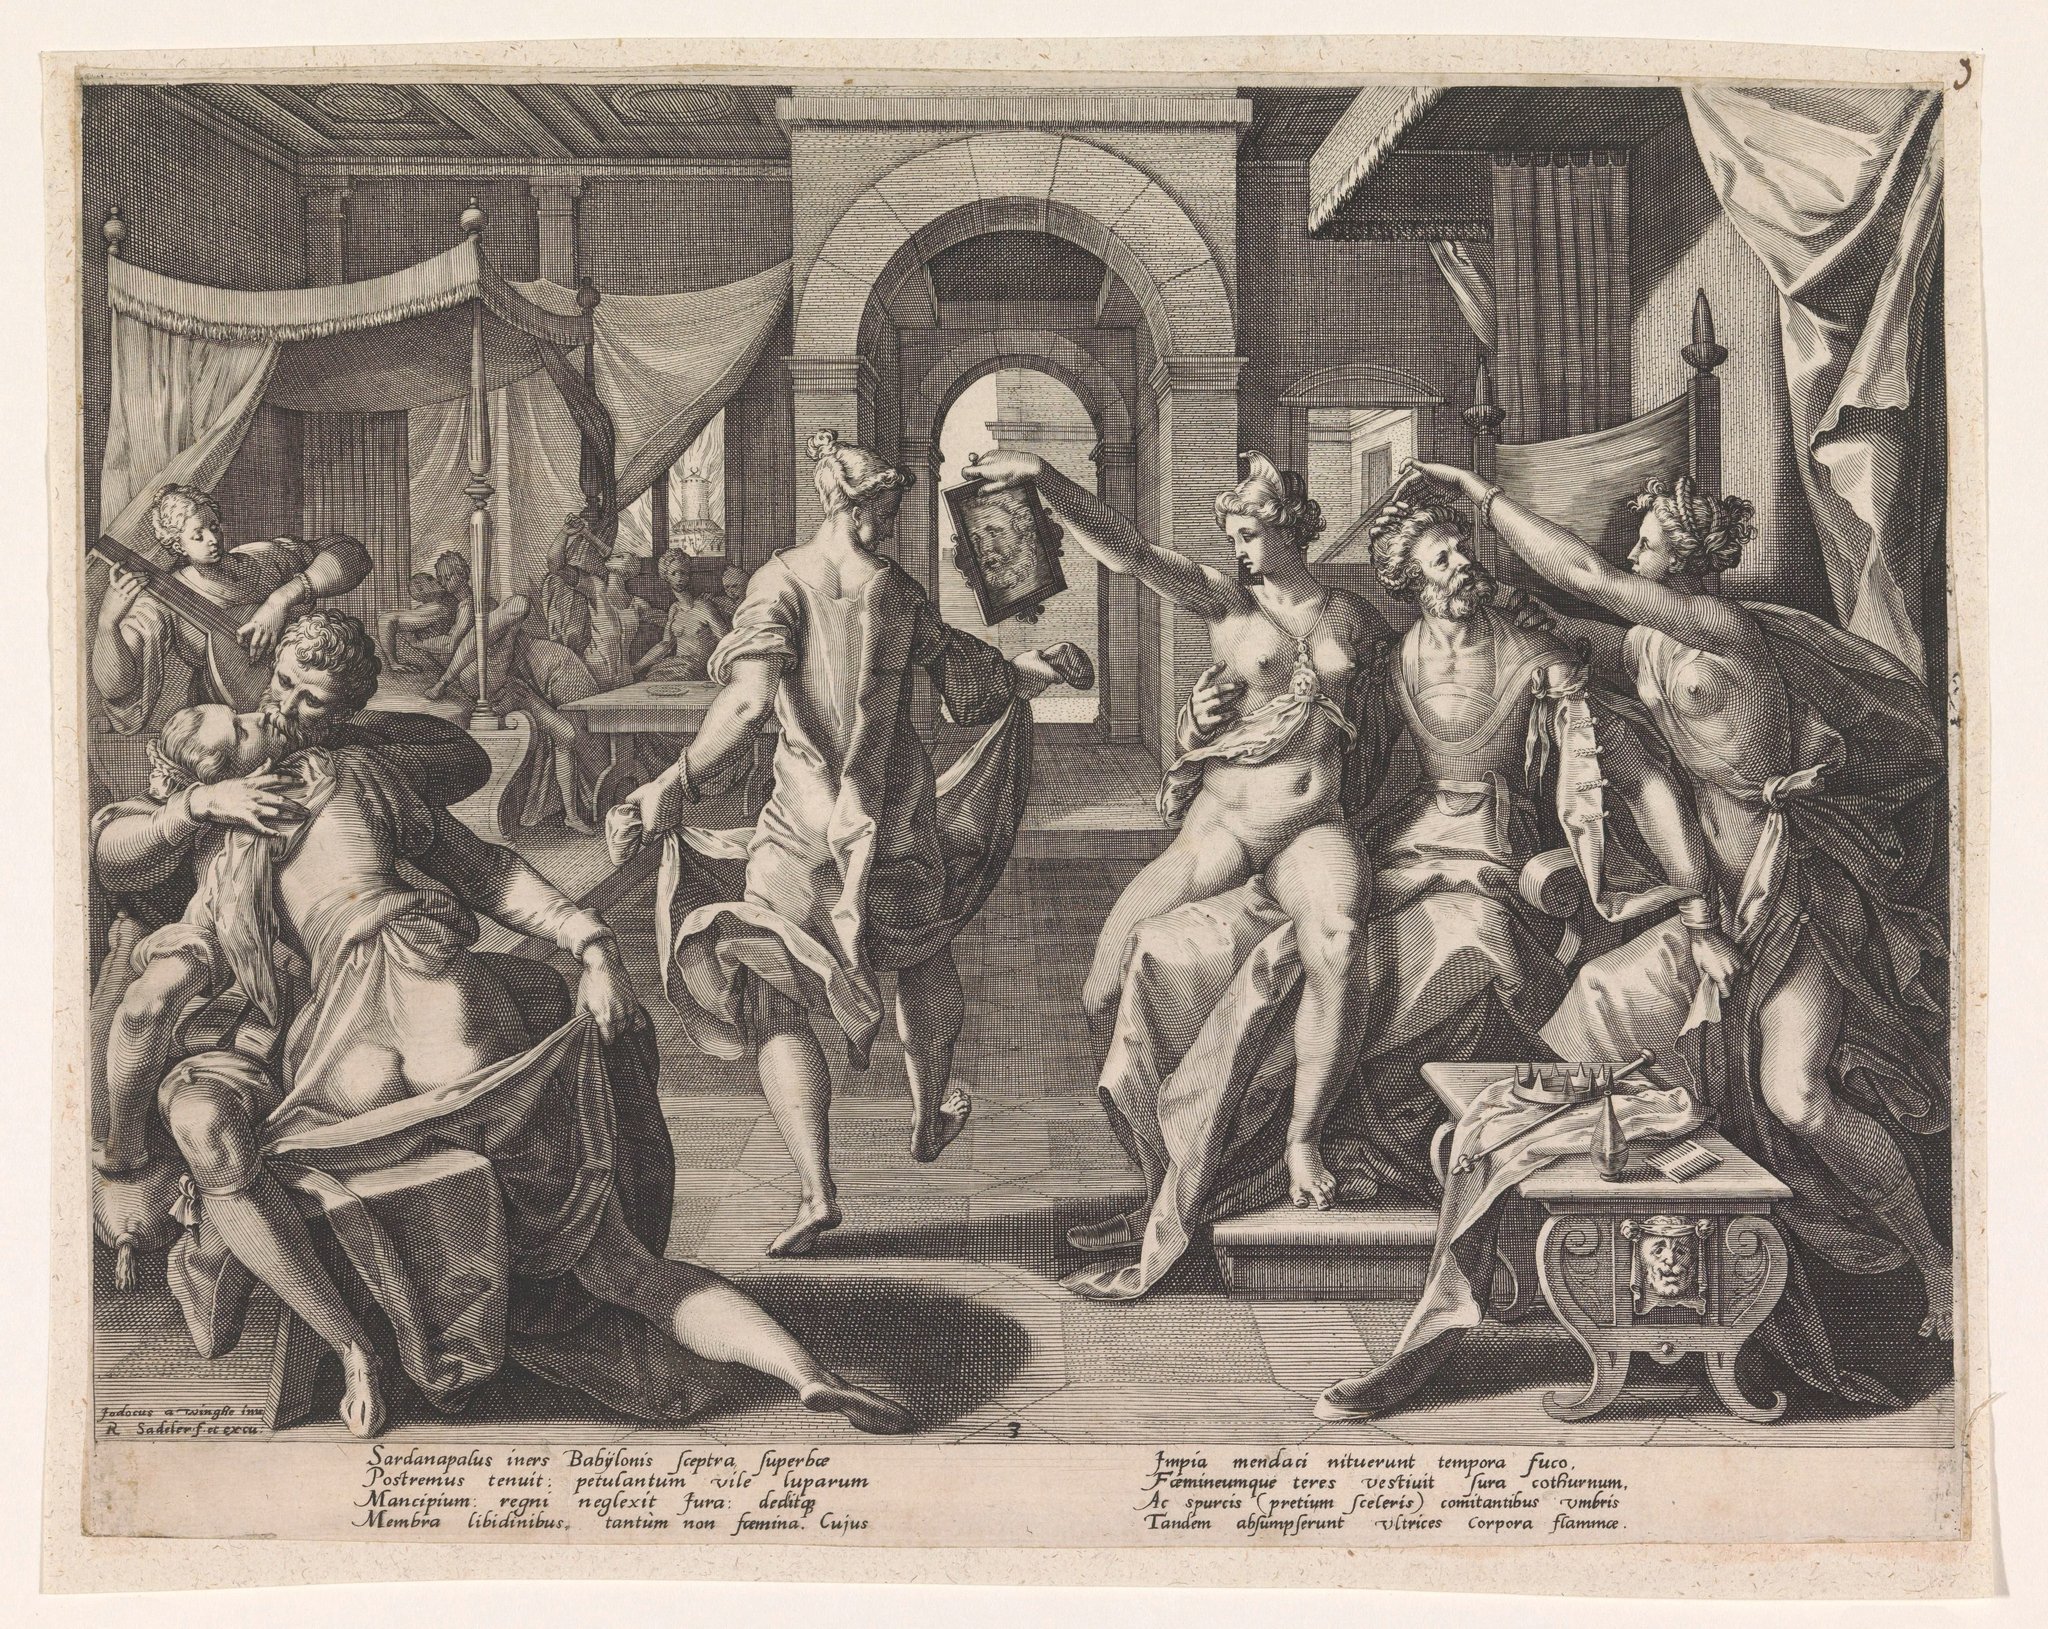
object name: print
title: Koning Sardanapal en zijn hofhouding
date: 1589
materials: paper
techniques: engraving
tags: male persons from classical history (sardanapolus) - non-aggressive activities of person from classical history, death of sardanapalus: before burning himself in his palace with all his treasures, he has his harem and his horses killed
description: Koning Sardanapal van Assyrië te midden van zijn hofhouding. Sardanapal zit op een troon en draagt vrouwenkleding. Een naakte vrouw zit op zijn schoot en toont hem een spiegel. Een andere vrouw kamt zijn haren. Links een vrijend paar. Op de achtergrond bedrijft een paar de liefde in het openbaar. In een doorkijk links op de achtergrond het lot van Sardanapal: zijn paleis gaat in vlammen op.